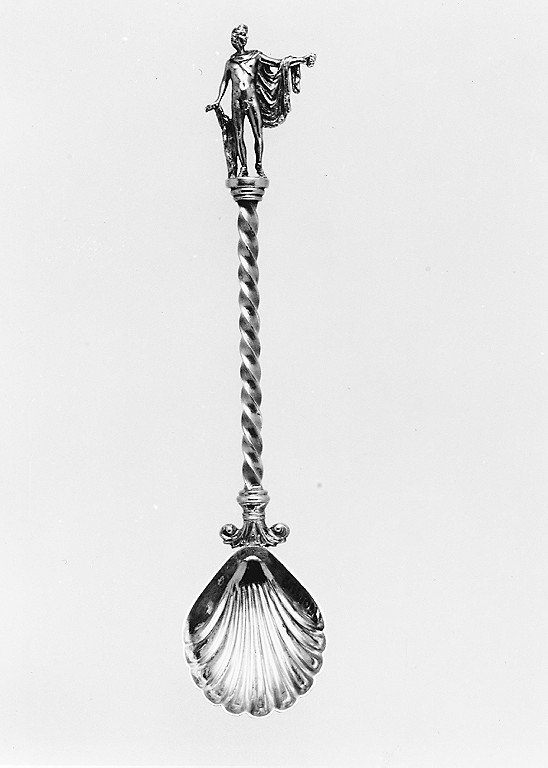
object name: souvenir spoon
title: Souvenir spoon with finial in the form of Apollo Belvedere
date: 1867-1900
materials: silver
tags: men